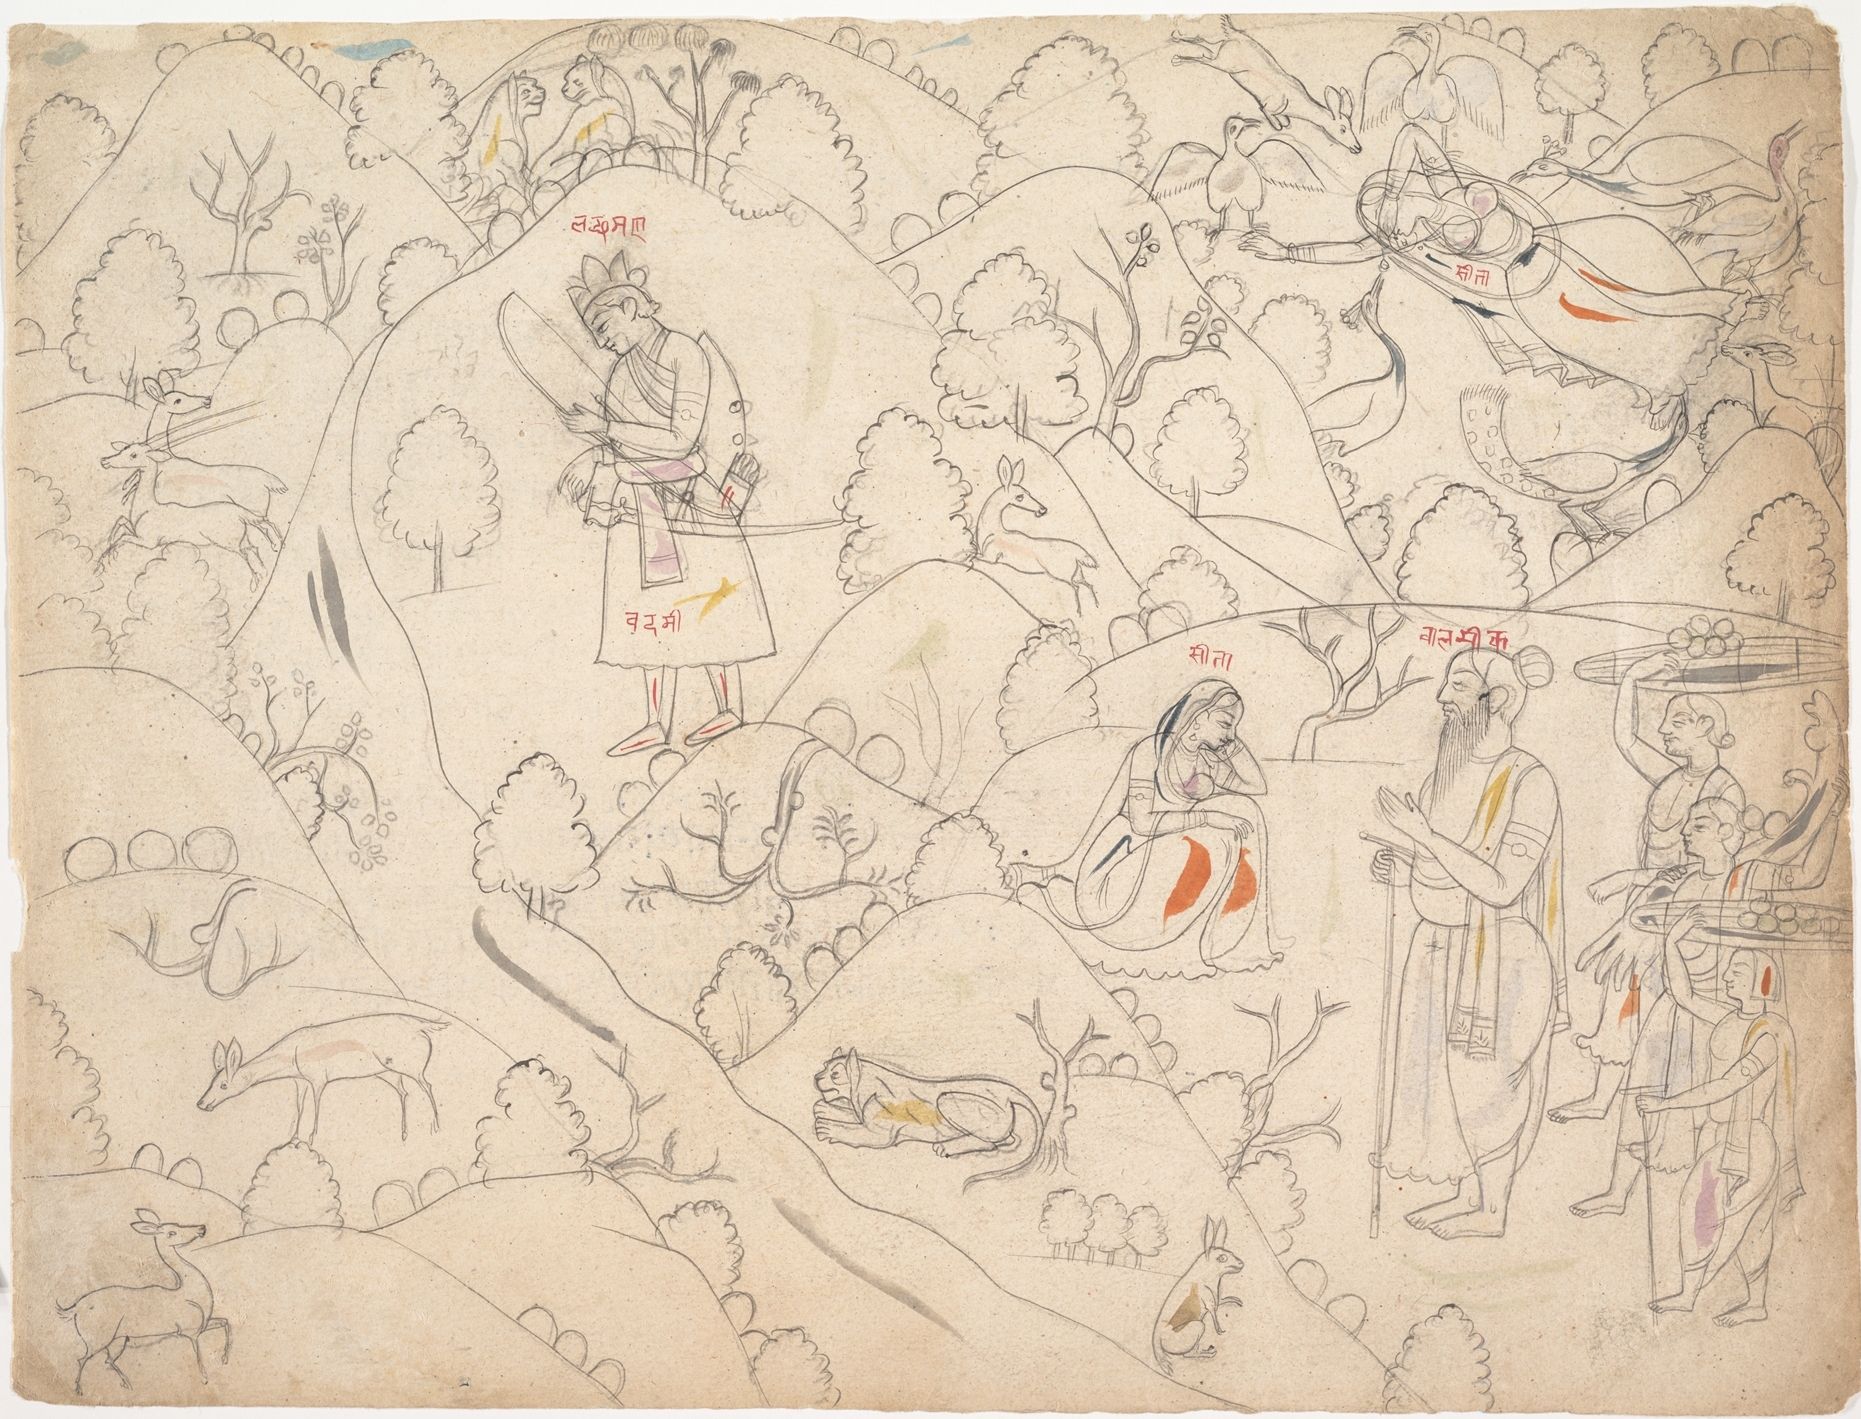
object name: folio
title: Page from a Dispersed Ramayana (Story of Rama)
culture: indian, kangra, punjab hills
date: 1801-1825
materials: graphite, paper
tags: birds,men,women,peacocks,deer